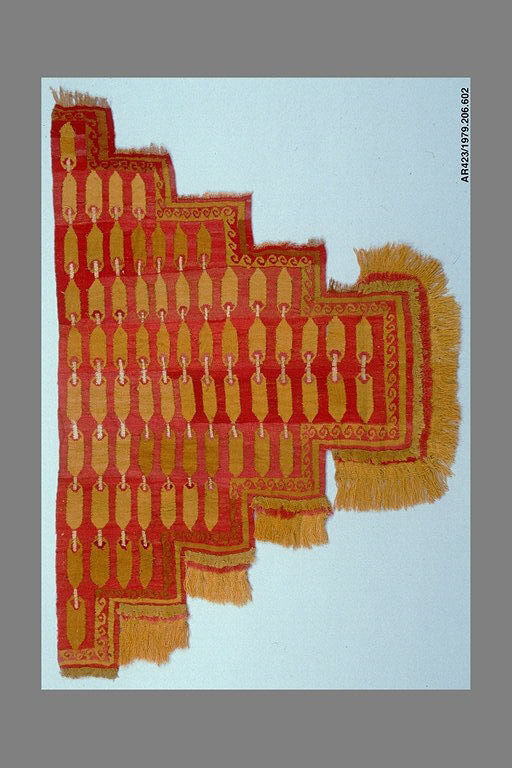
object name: tunic panel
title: Tunic Shoulder Panel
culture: chimú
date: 1101-1500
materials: animal fiber, cotton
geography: peru